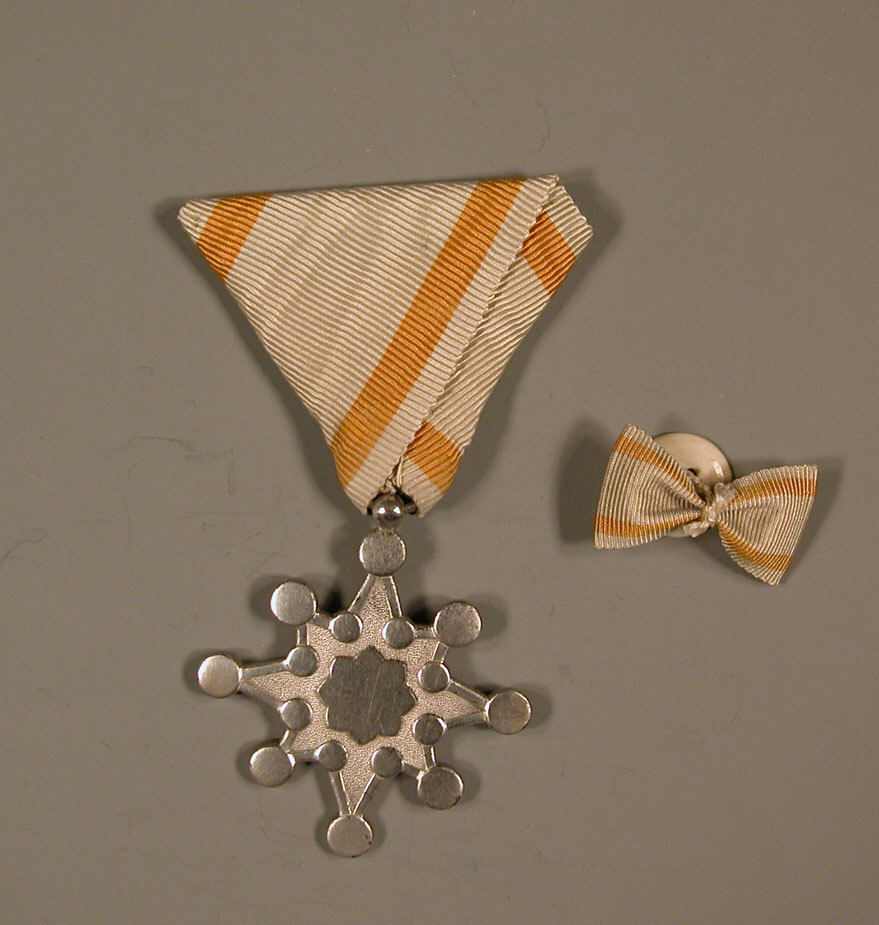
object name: medal and button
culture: japanese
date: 1867-1900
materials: ribbon